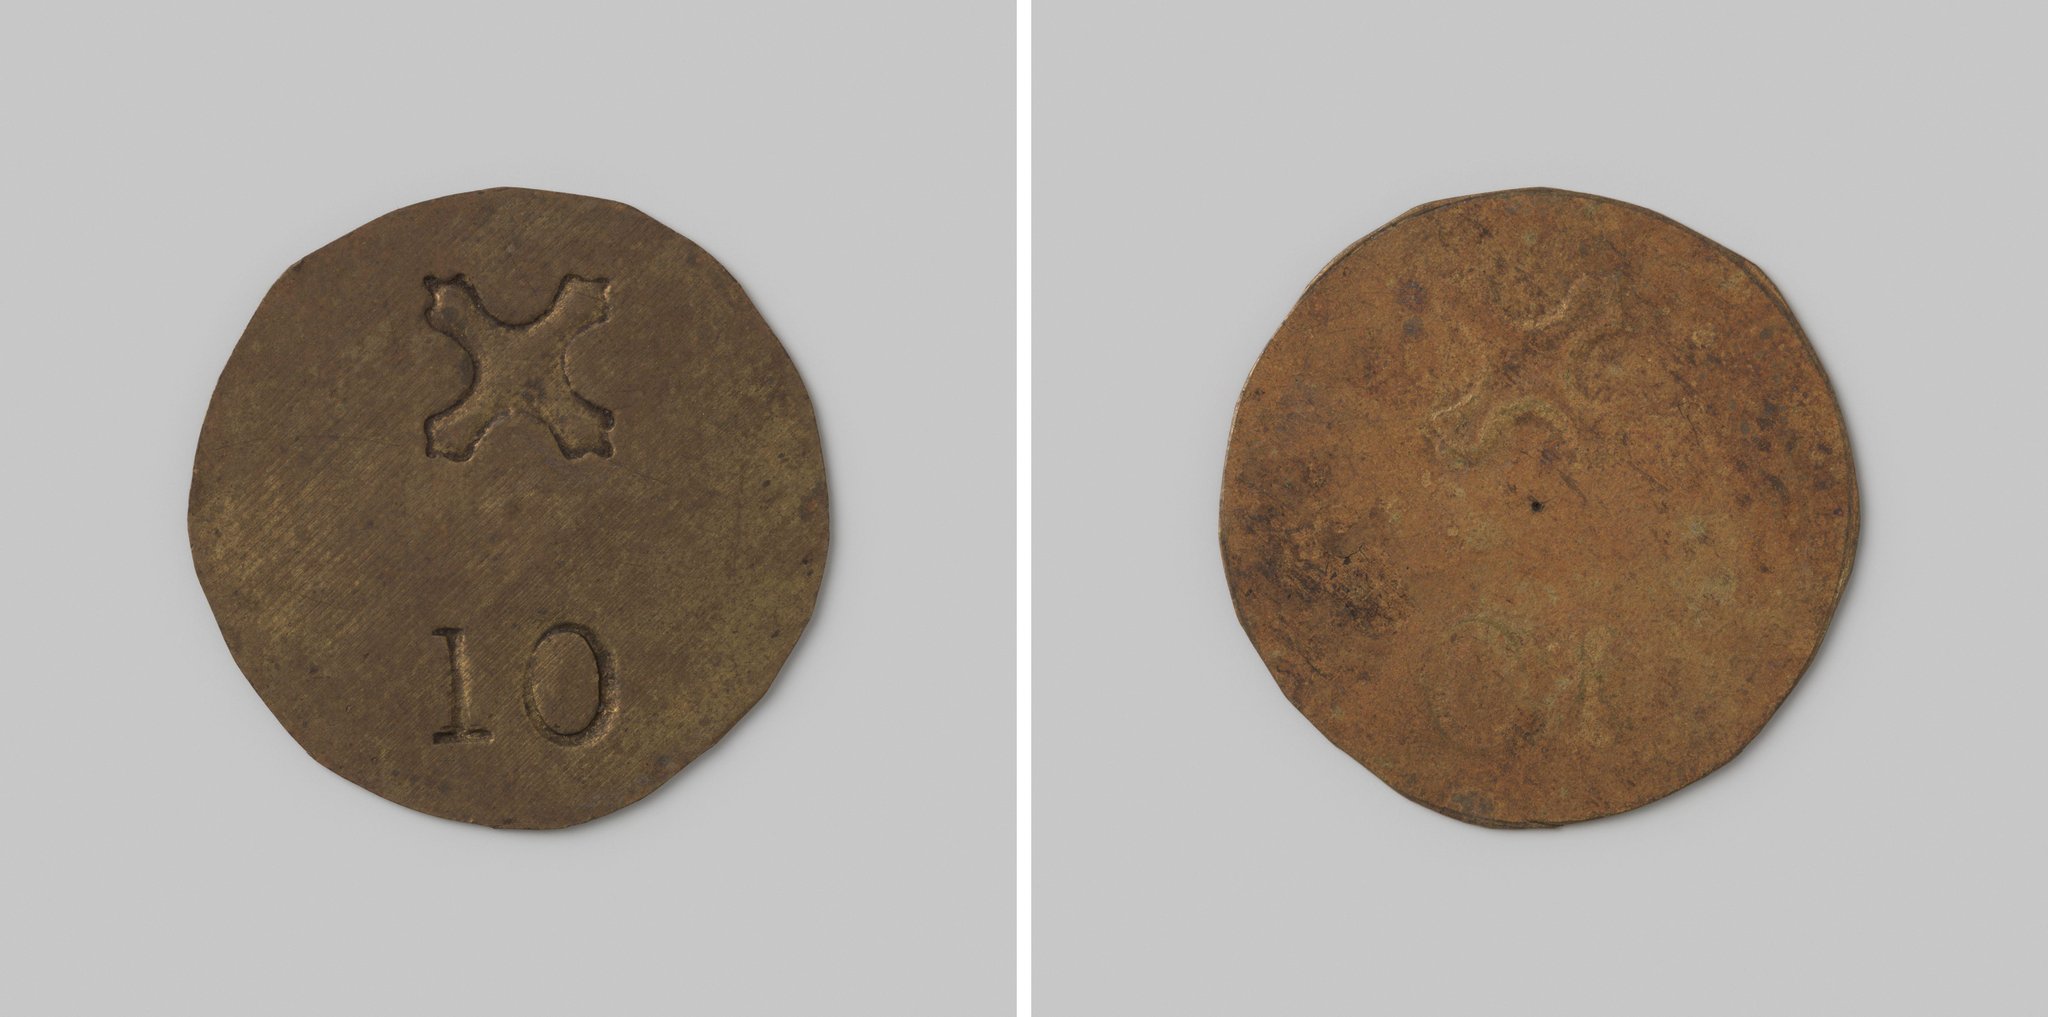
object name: tien cent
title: Betaalpenning van tien cent van de Coöperatieve Winkelvereeniging De Volharding te Veenendaal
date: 1875-1900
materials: brass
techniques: printing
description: Rond messing plaatje met instempelingen (andreaskruis) / 10